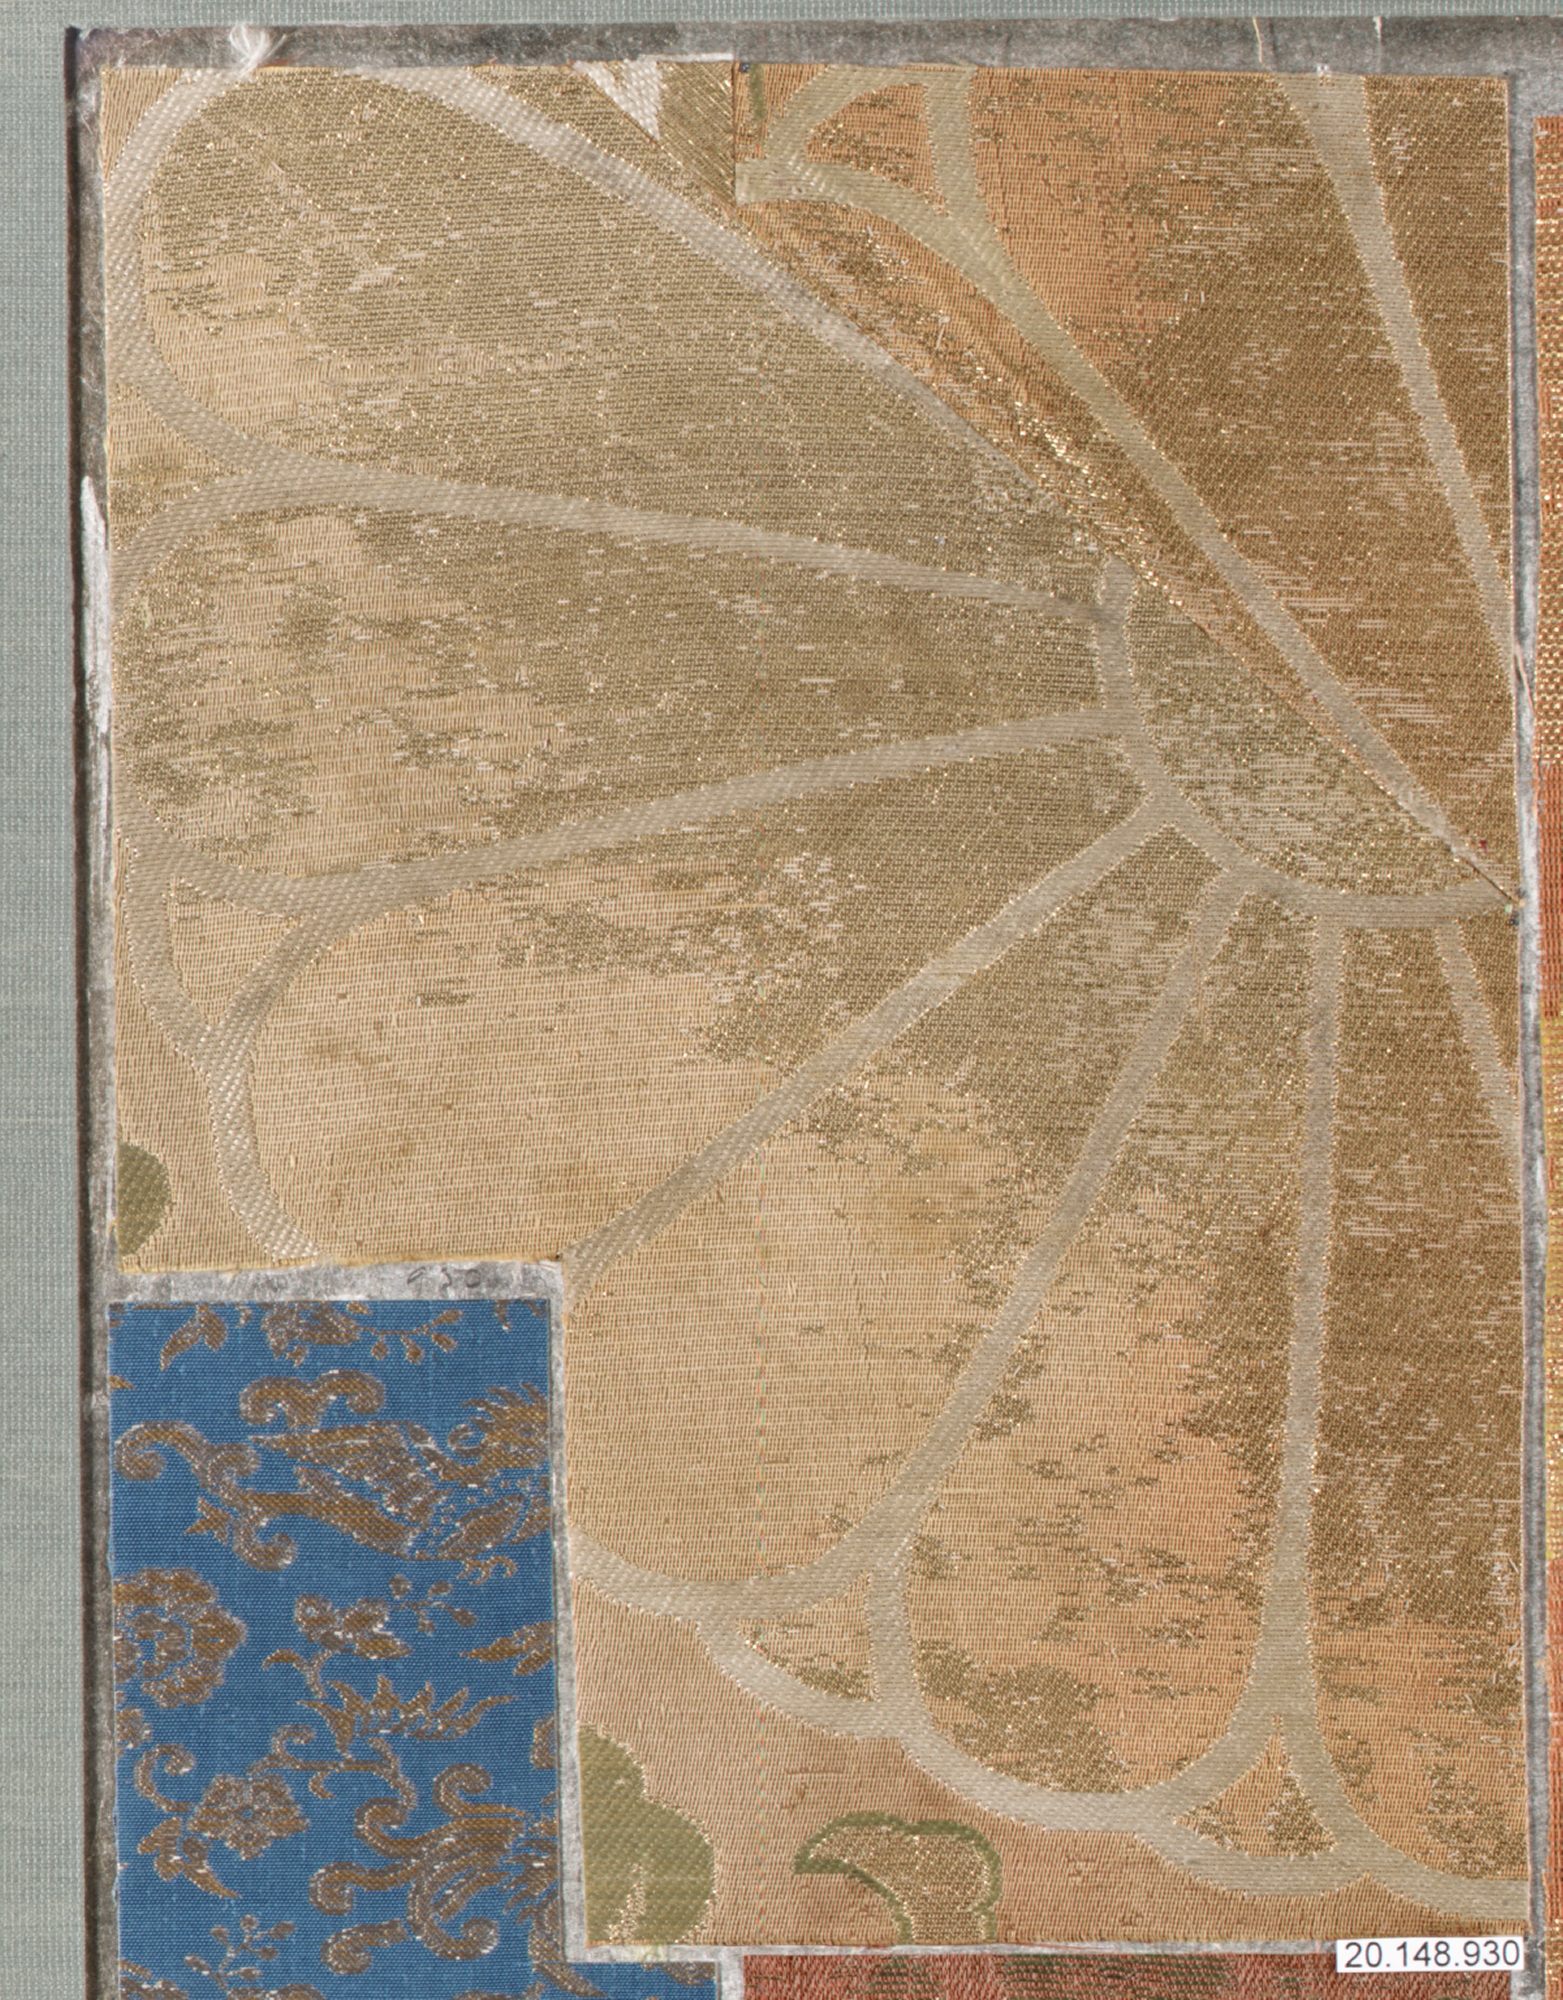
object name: piece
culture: japanese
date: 1701-1800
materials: silk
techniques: compound weave